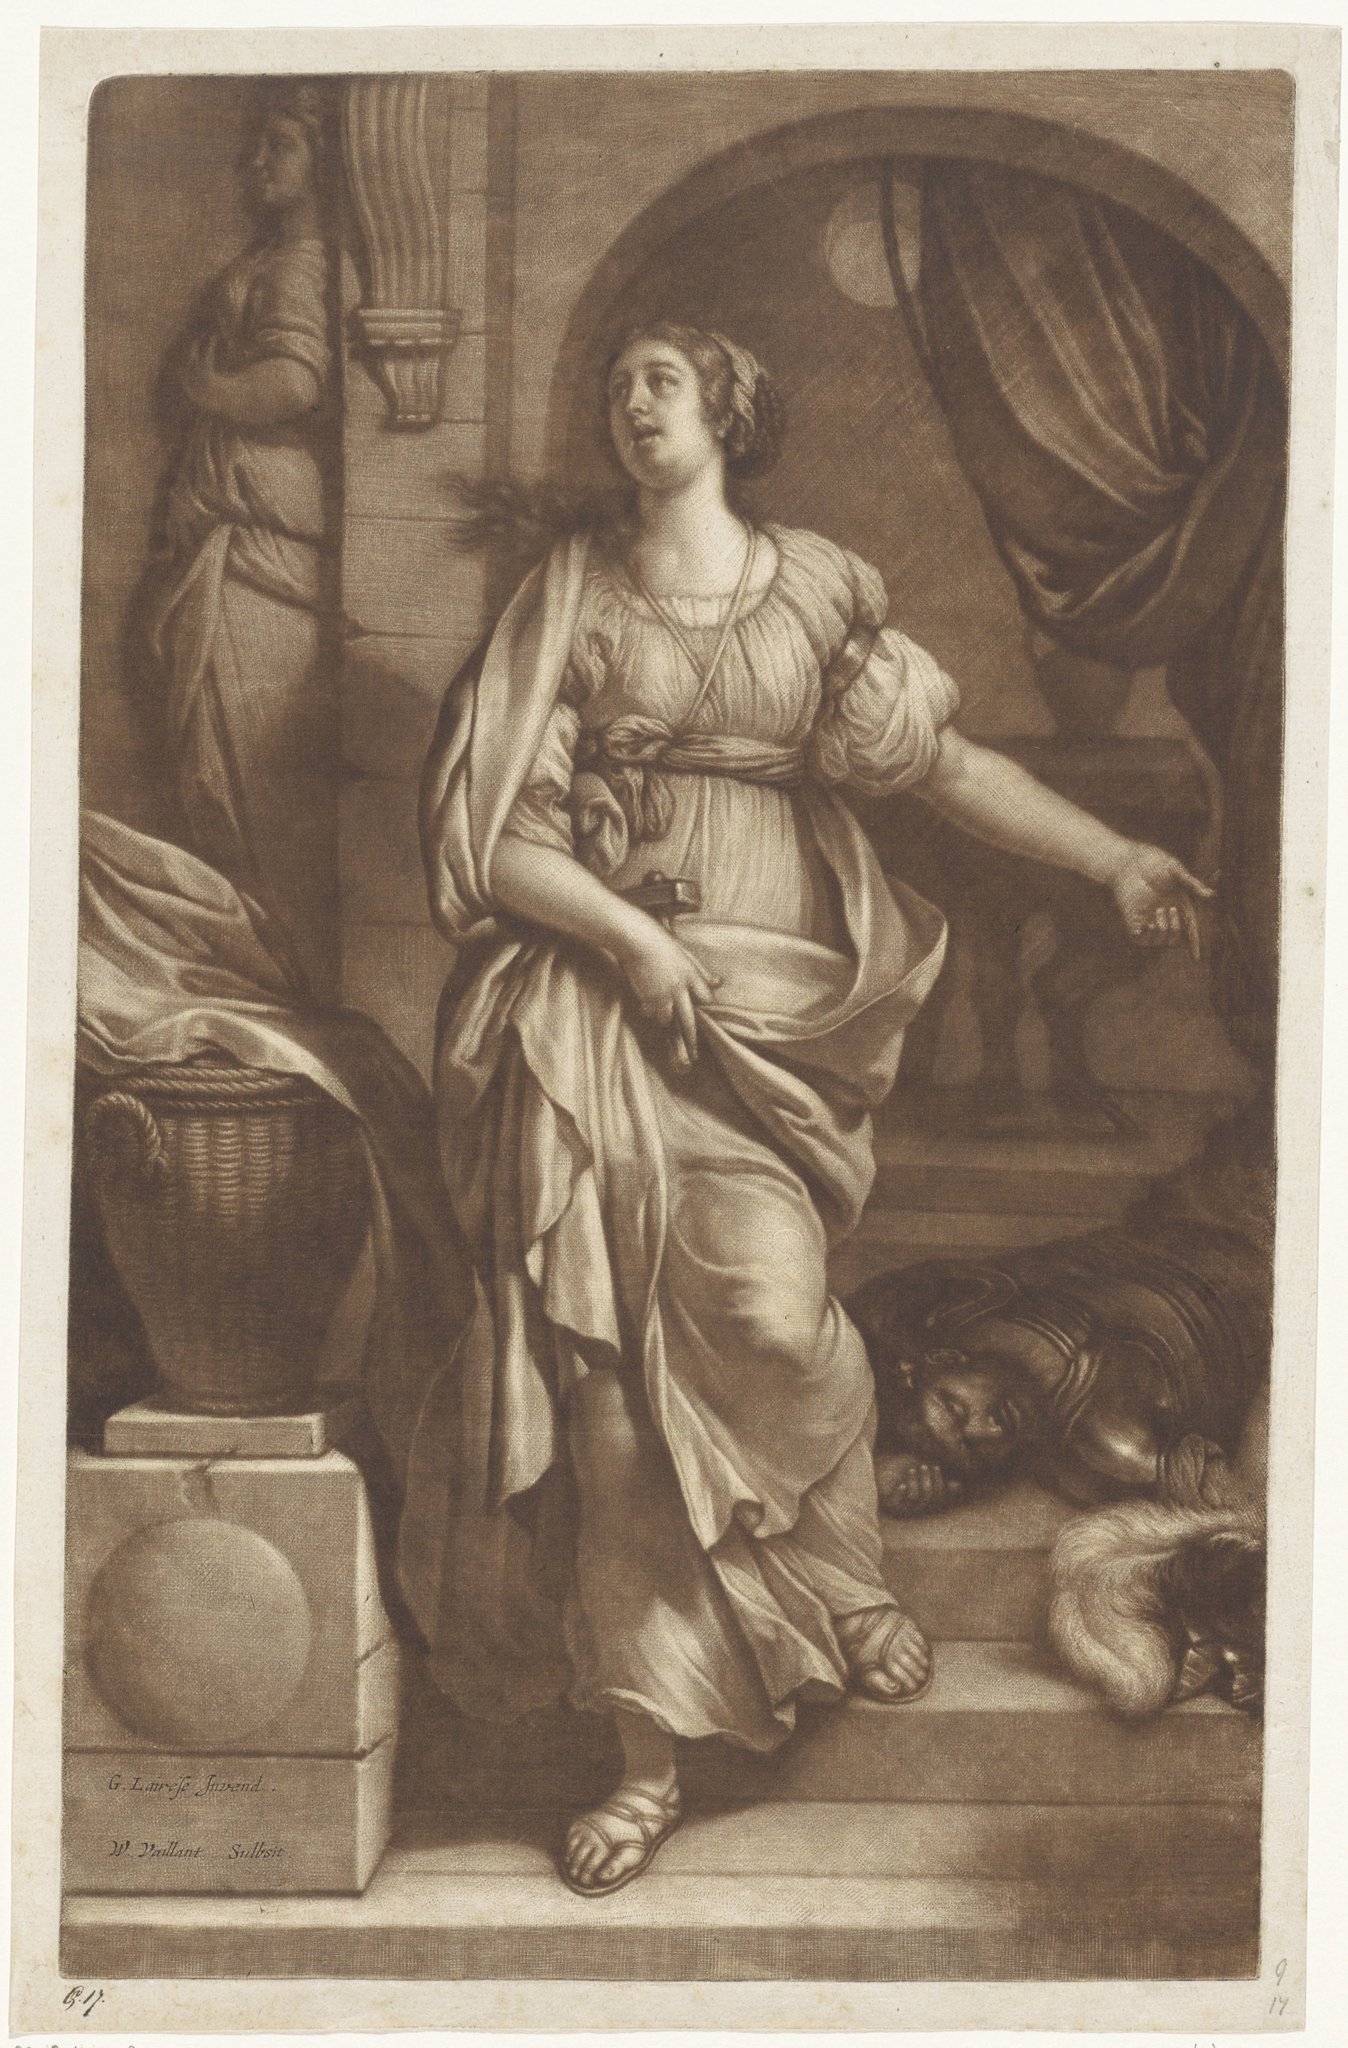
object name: print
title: Jaël en Sisera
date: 1658-1677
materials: paper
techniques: mezzotint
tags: story of jael and sisera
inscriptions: collector's mark: Lugt 11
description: Jaël heeft de legerleider Sisera gedood. In haar hand de hamer waarmee ze een tentharing door zijn slapen sloeg. Op de achtergrond ligt het levenloze lichaam van Sisera.